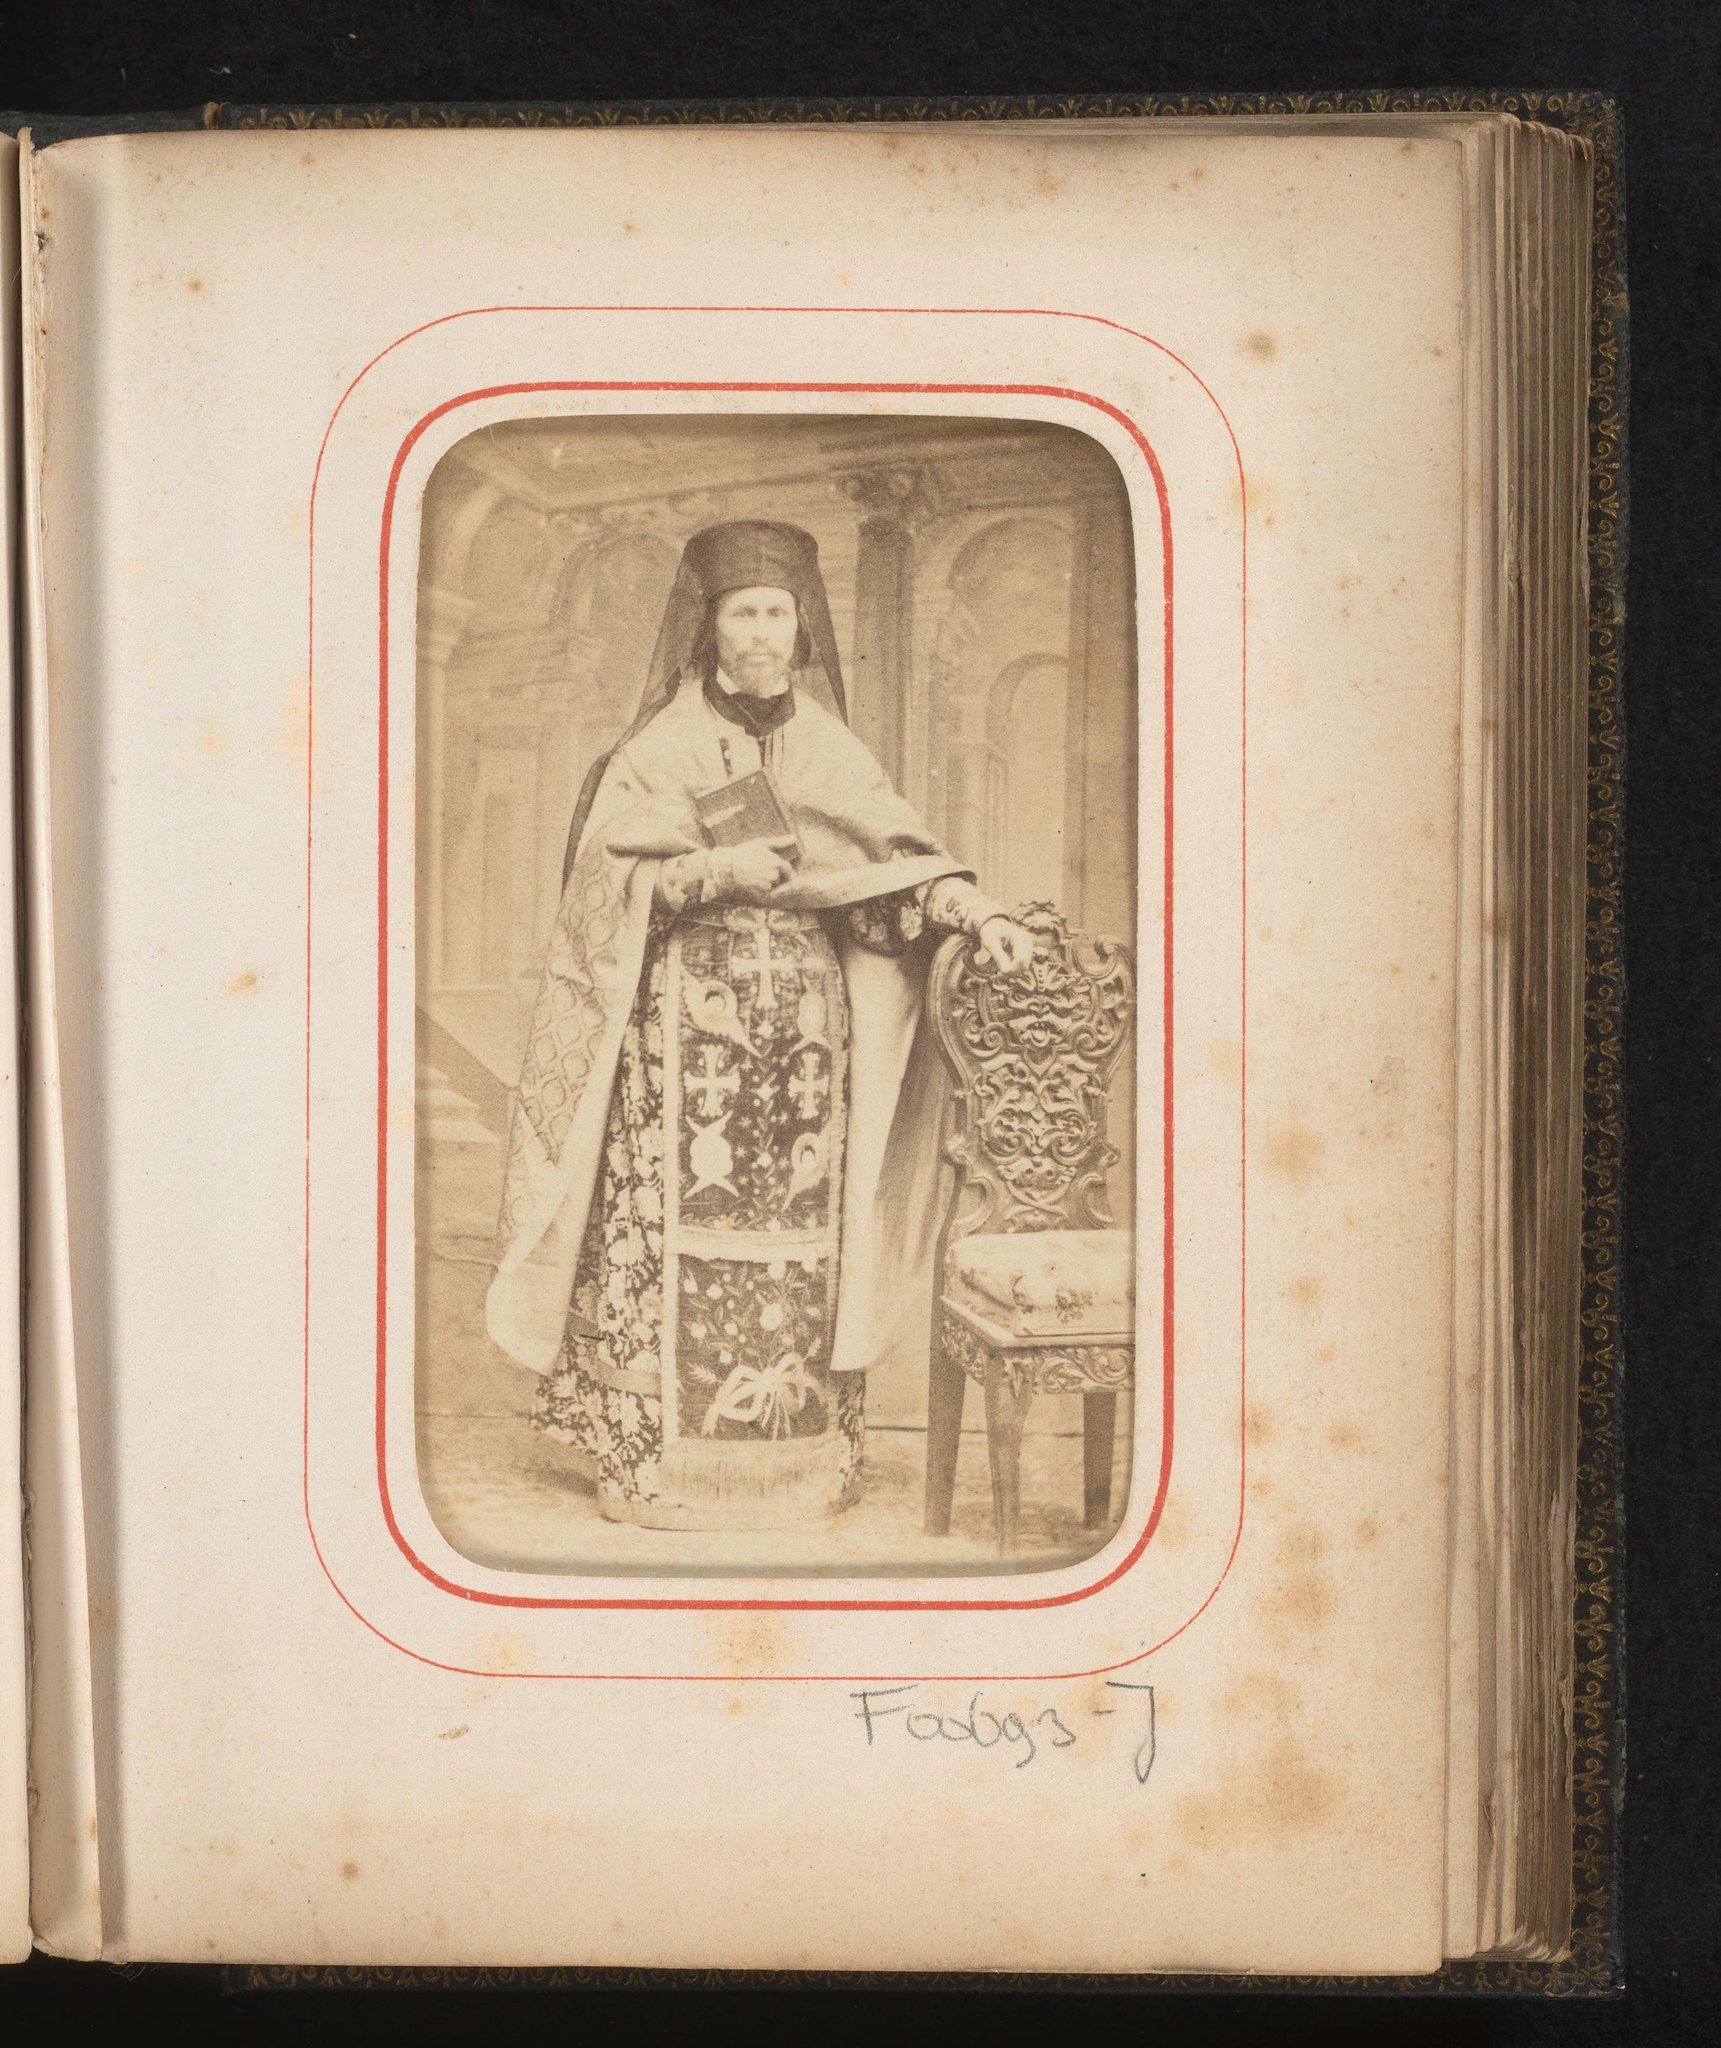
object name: photograph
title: Portret van een Roemeens-Orthodoxe priester met bijbel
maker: carol popp de szathmari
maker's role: fotograaf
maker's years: 1812-1887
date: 1870-1890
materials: cardboard, photographic support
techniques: albumen print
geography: bucharest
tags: orthodox churches, historical persons, the bible as a book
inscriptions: inscription: ‘CHARLES SZATHMARI/ Peintre et Photographe de la Cour/ DE SALE PRINCE REGNANT/ des Principautées unies Roumaines./ (...)/ BUCAREST.’